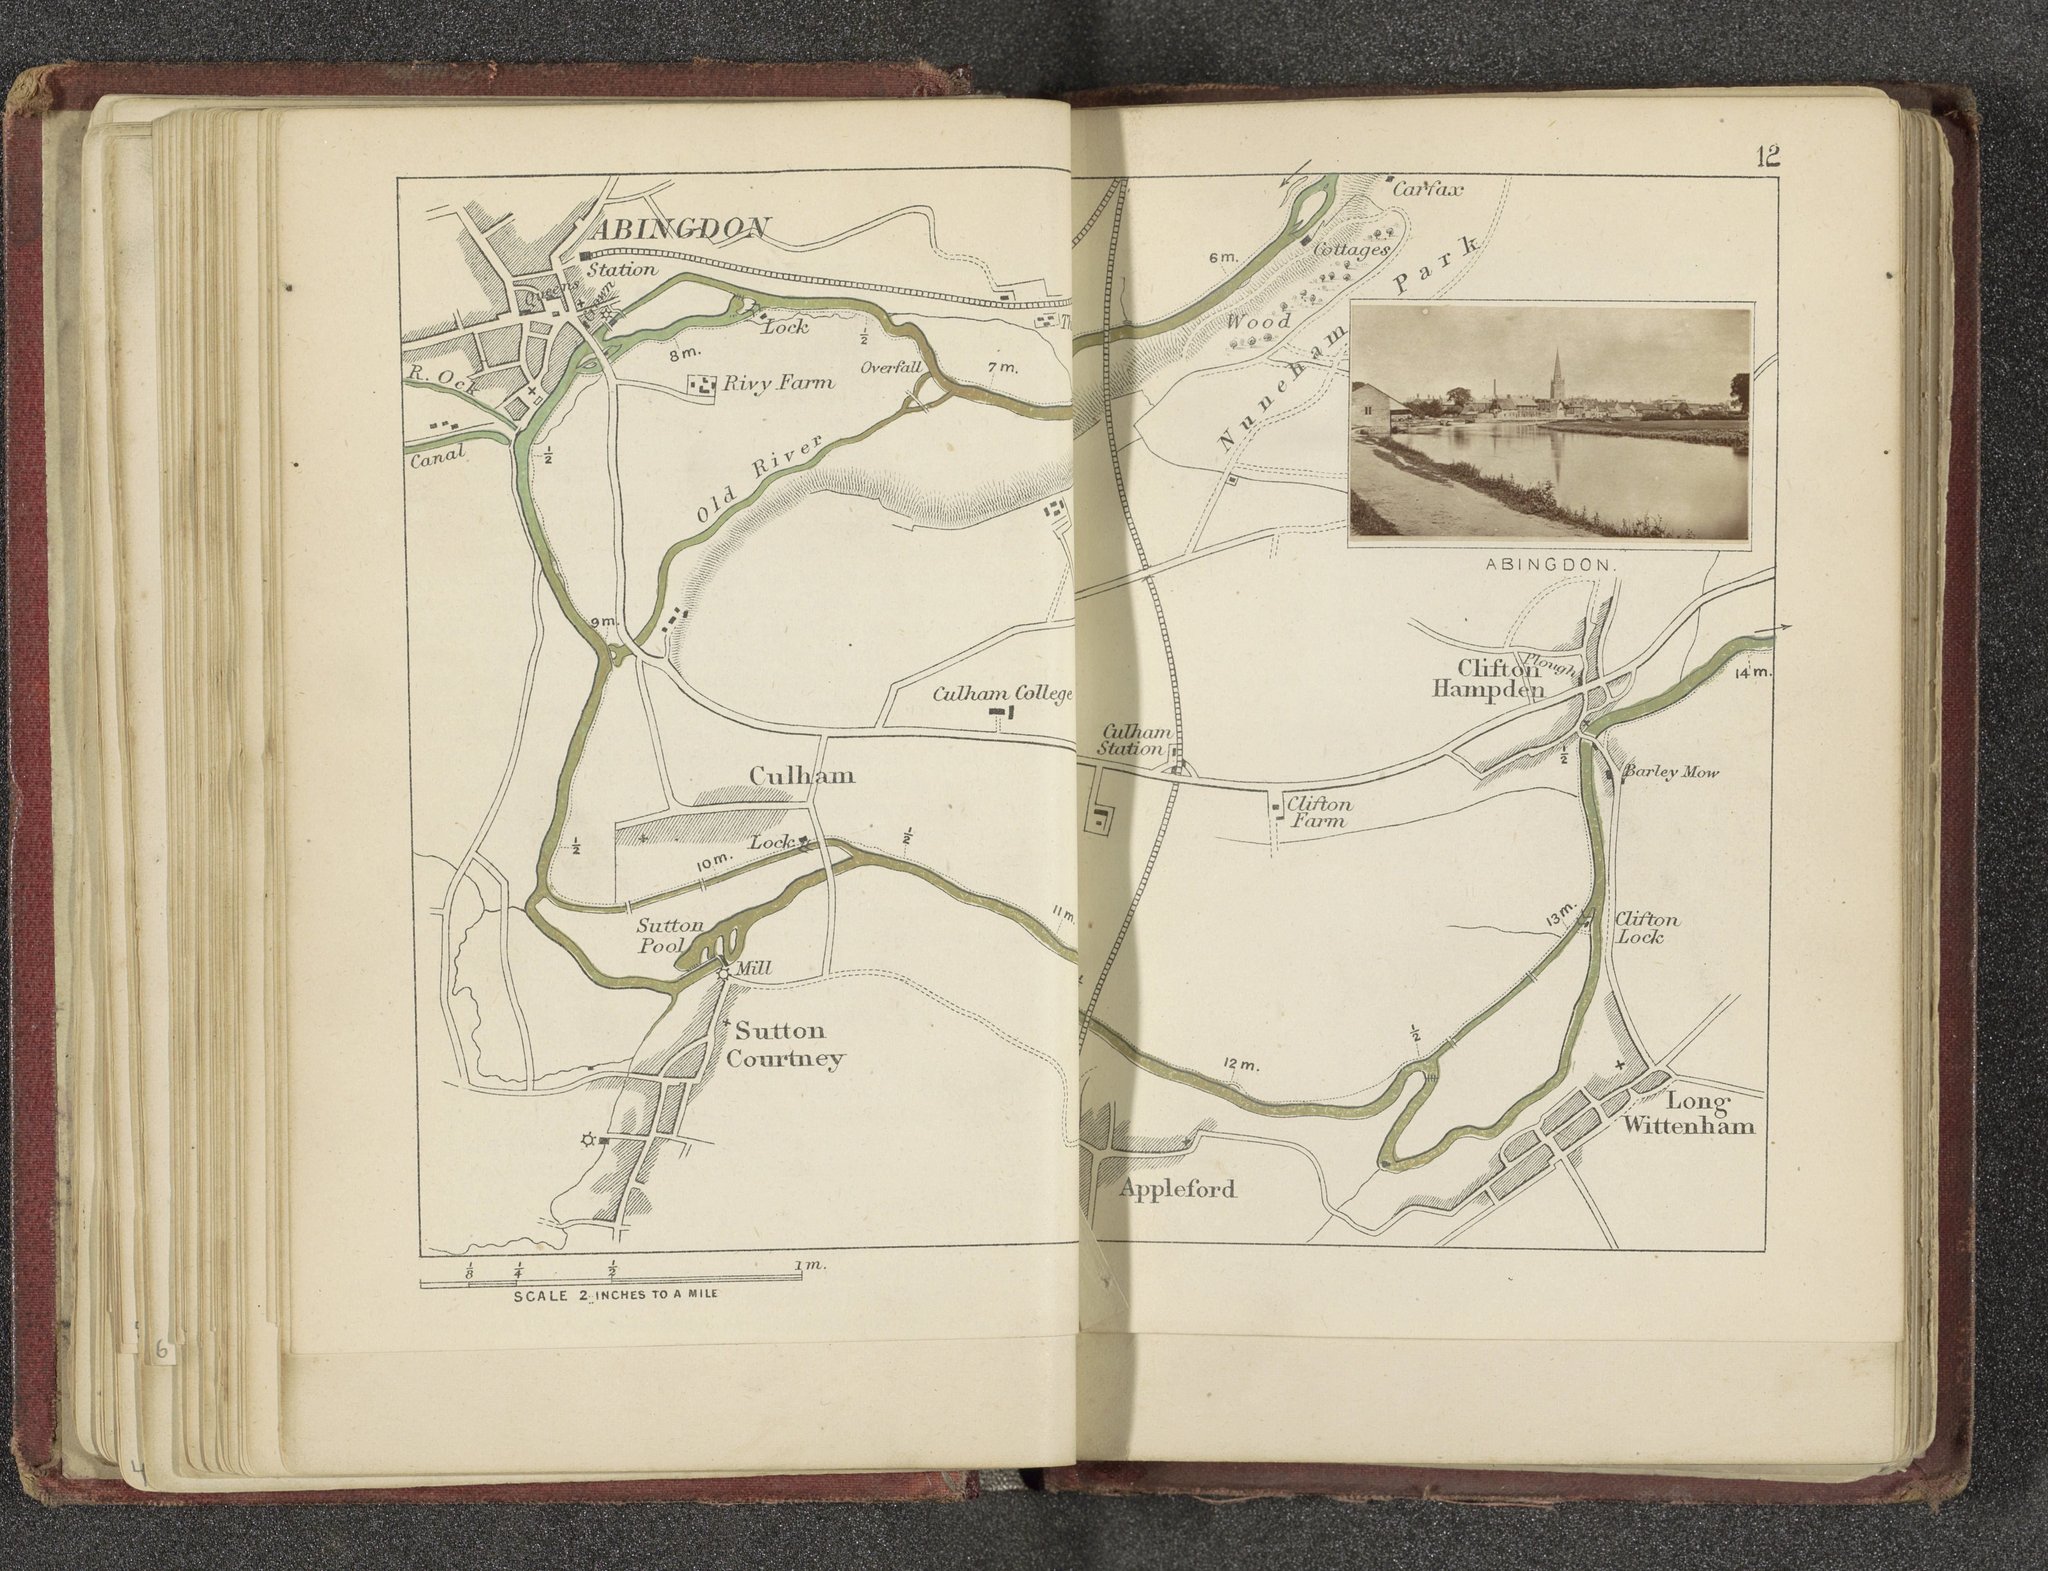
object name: print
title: Kaart met een een gezicht op Abingdon over de Theems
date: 1878-1879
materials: paper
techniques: engraving, woodburytype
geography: oxfordshire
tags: city-view, and landscape with man-made constructions, river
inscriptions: inscription: ‘Abingdon.’, number: ‘12’